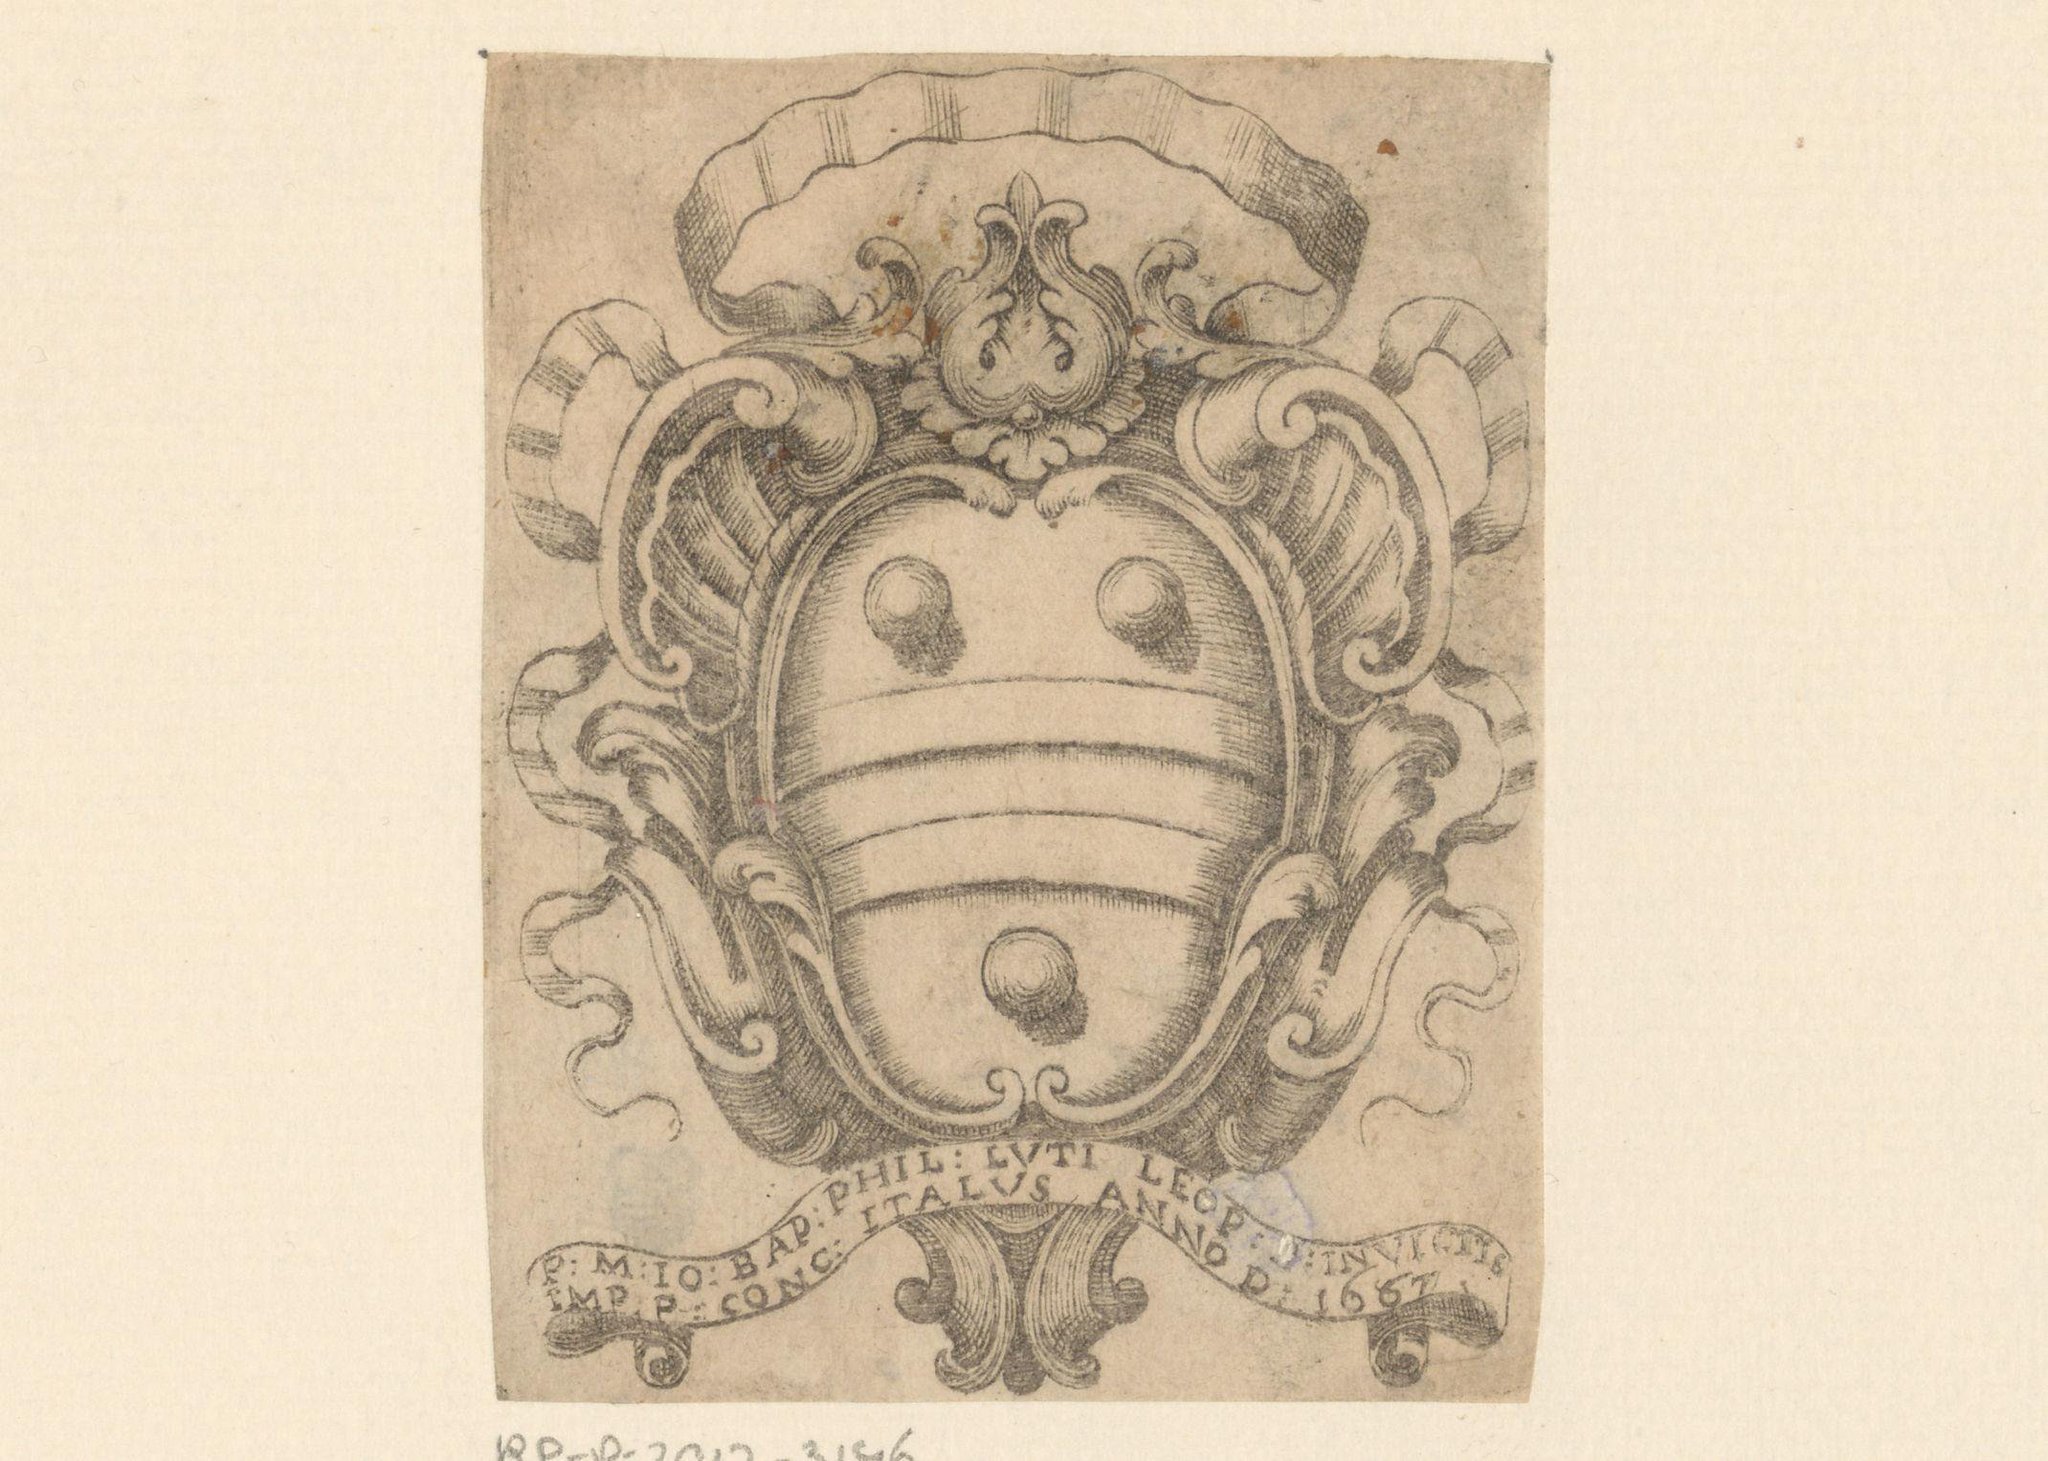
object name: bookplate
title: Io: Bap: Phil: Luti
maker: Anonymous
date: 1667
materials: paper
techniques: etching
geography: italy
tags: armorial bearing, heraldry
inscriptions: collector's mark: Lugt 2760